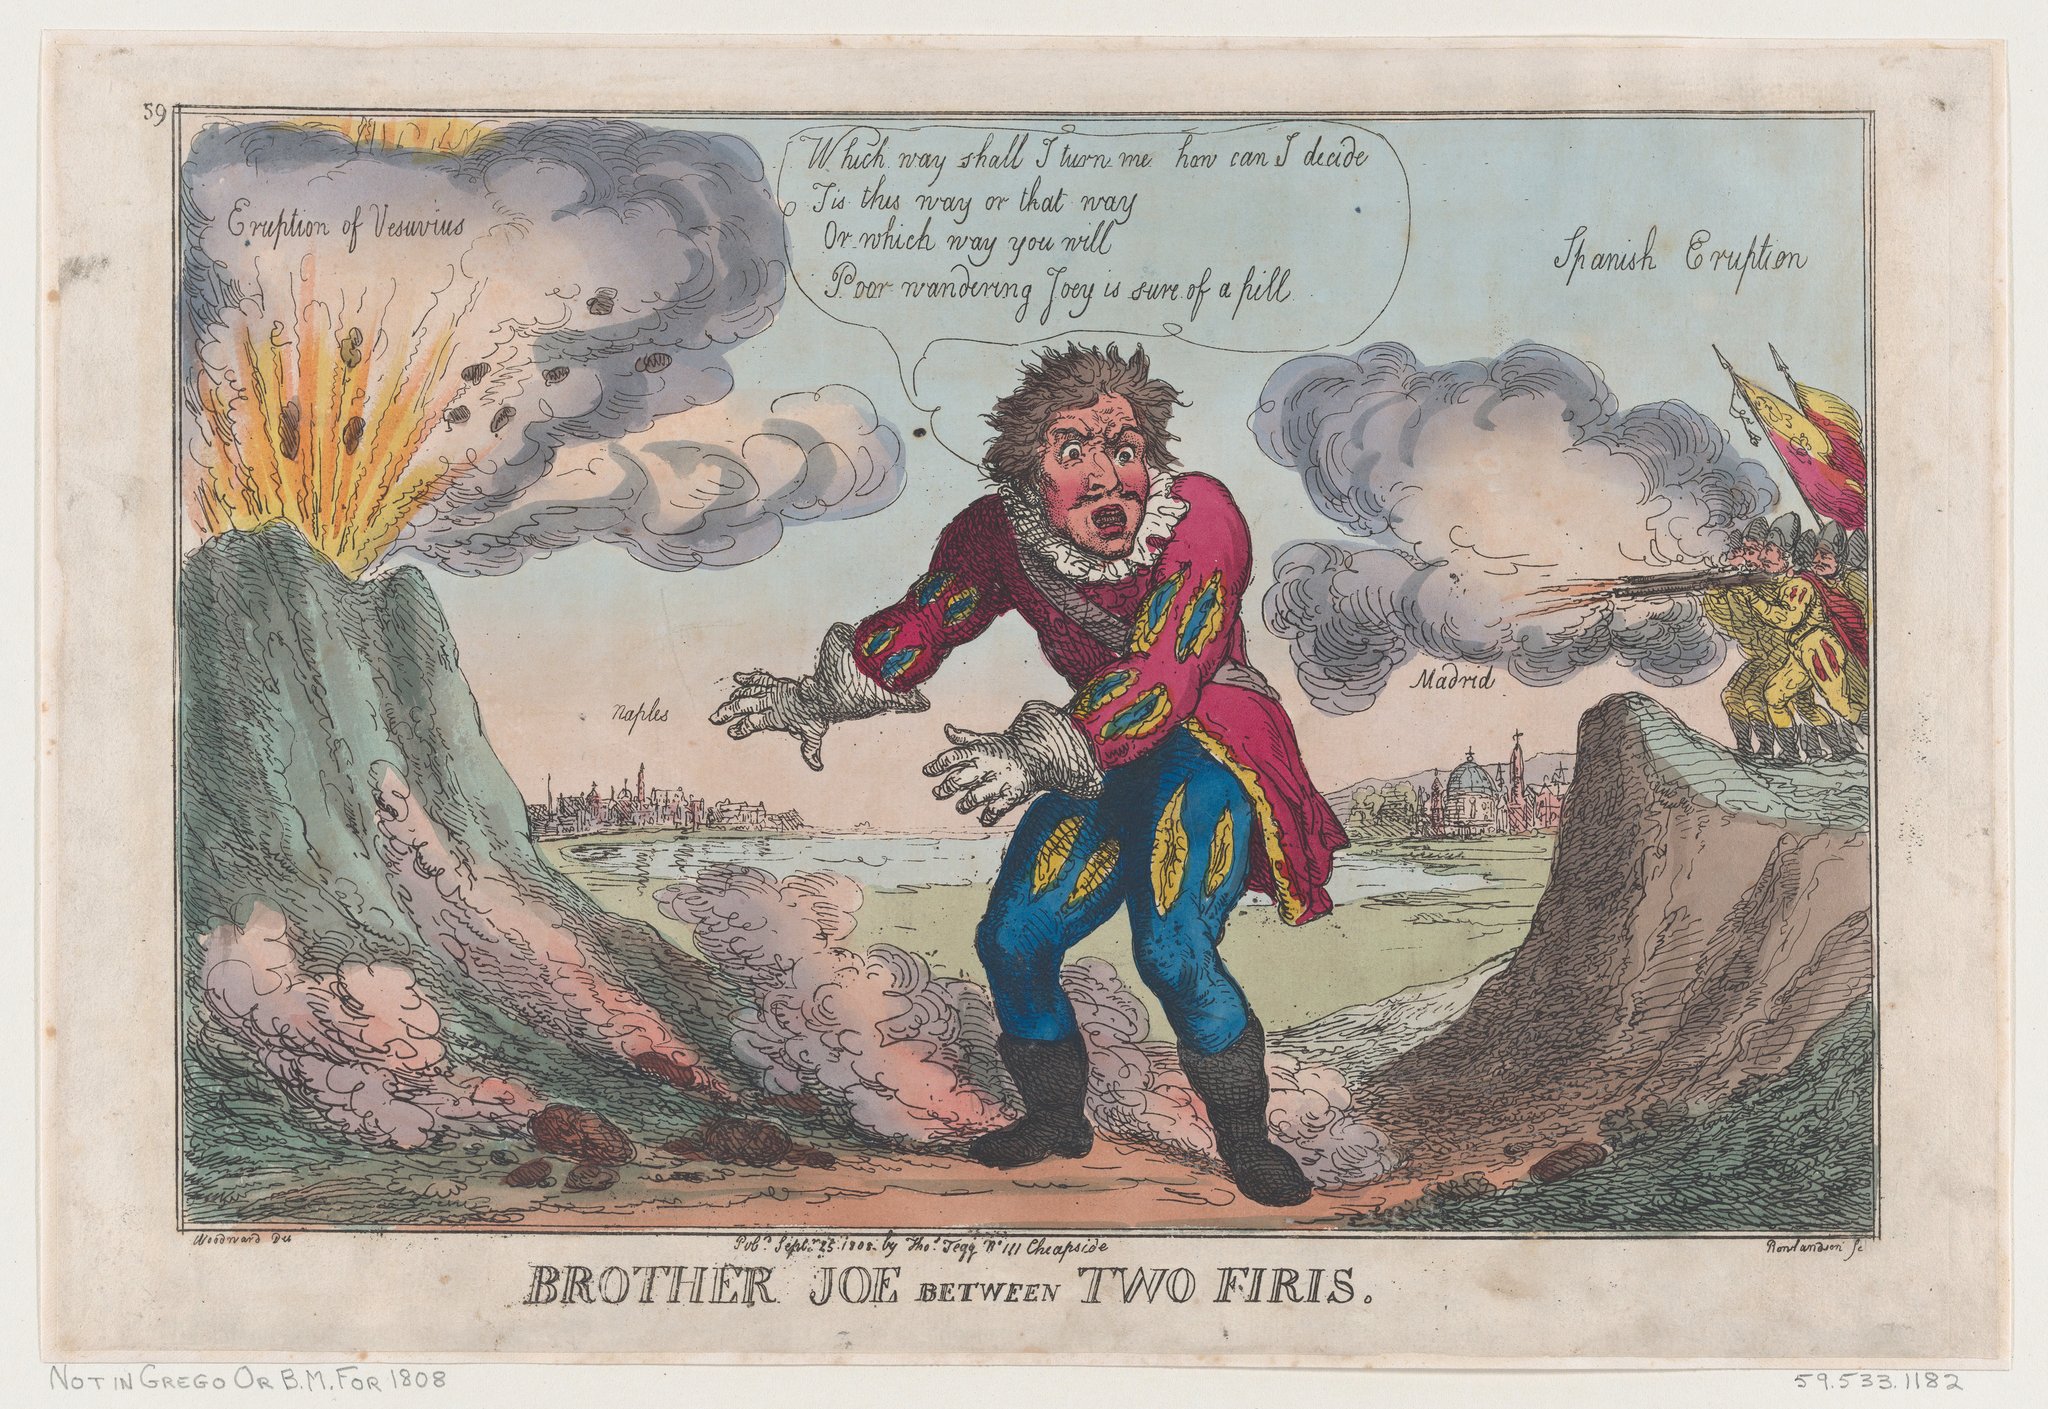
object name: print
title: Brother Joe Between Two Firis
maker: thomas rowlandson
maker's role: artist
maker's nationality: british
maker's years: 1757-1827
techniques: etching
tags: satire,men,fires,politics